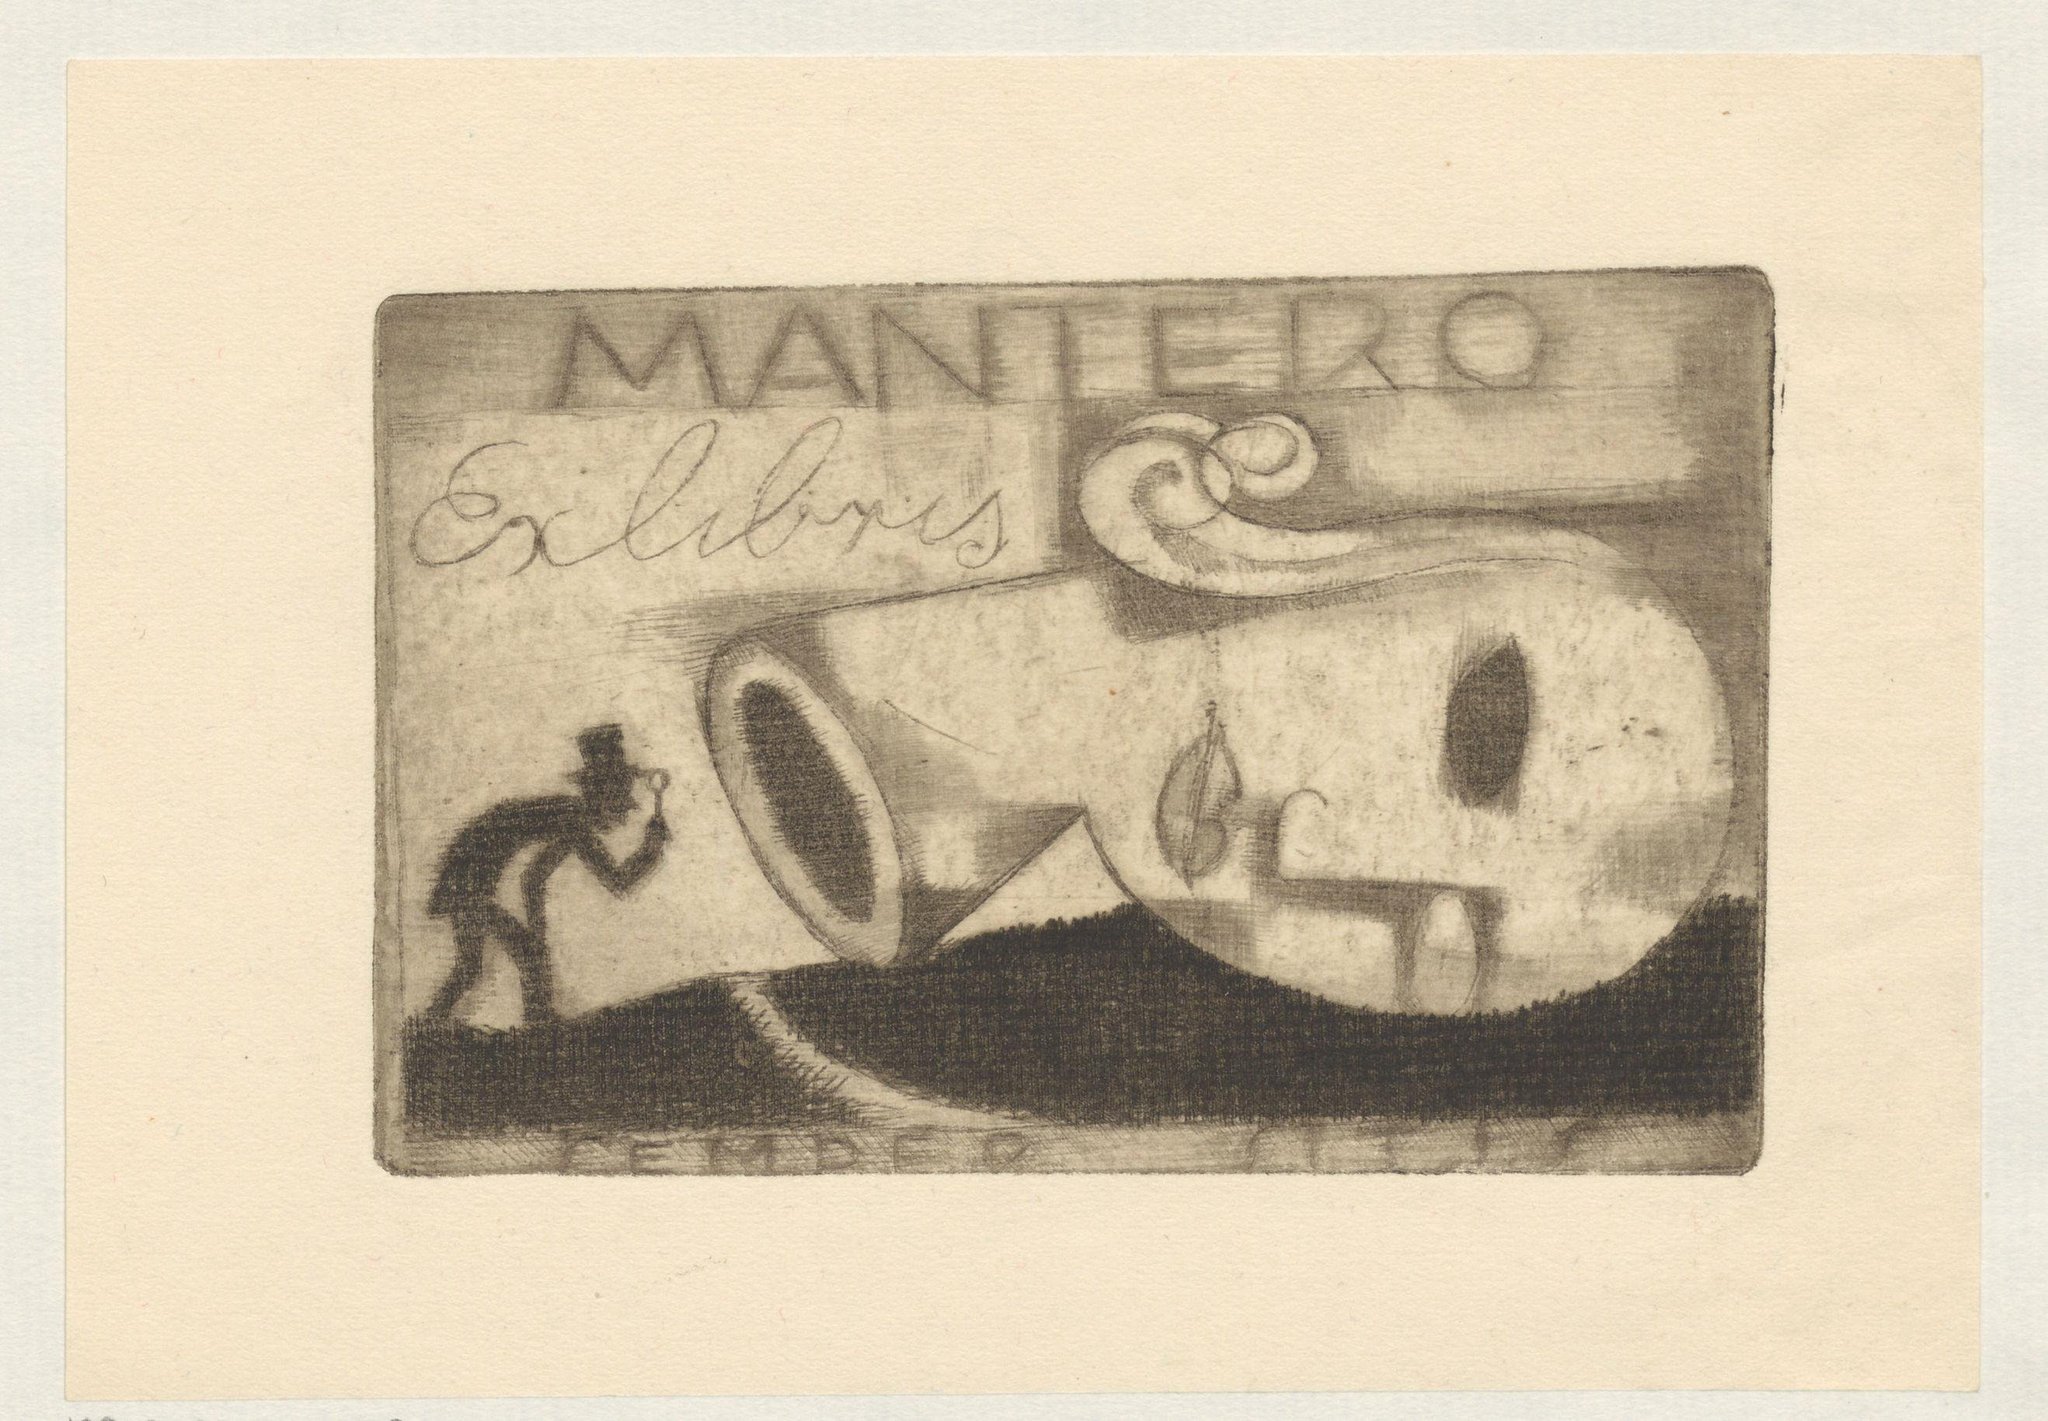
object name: bookplate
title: Ex libris van Mantero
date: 1930-1960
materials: paper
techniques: photograph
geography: italy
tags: gianni mantero, head (human), magnifying glass, sculpture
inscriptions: workshop stamp: ‘Michel Fingesten / Milano / Punta secca originale / Pointe seche originale / Orig. kalte Nädel-rad’